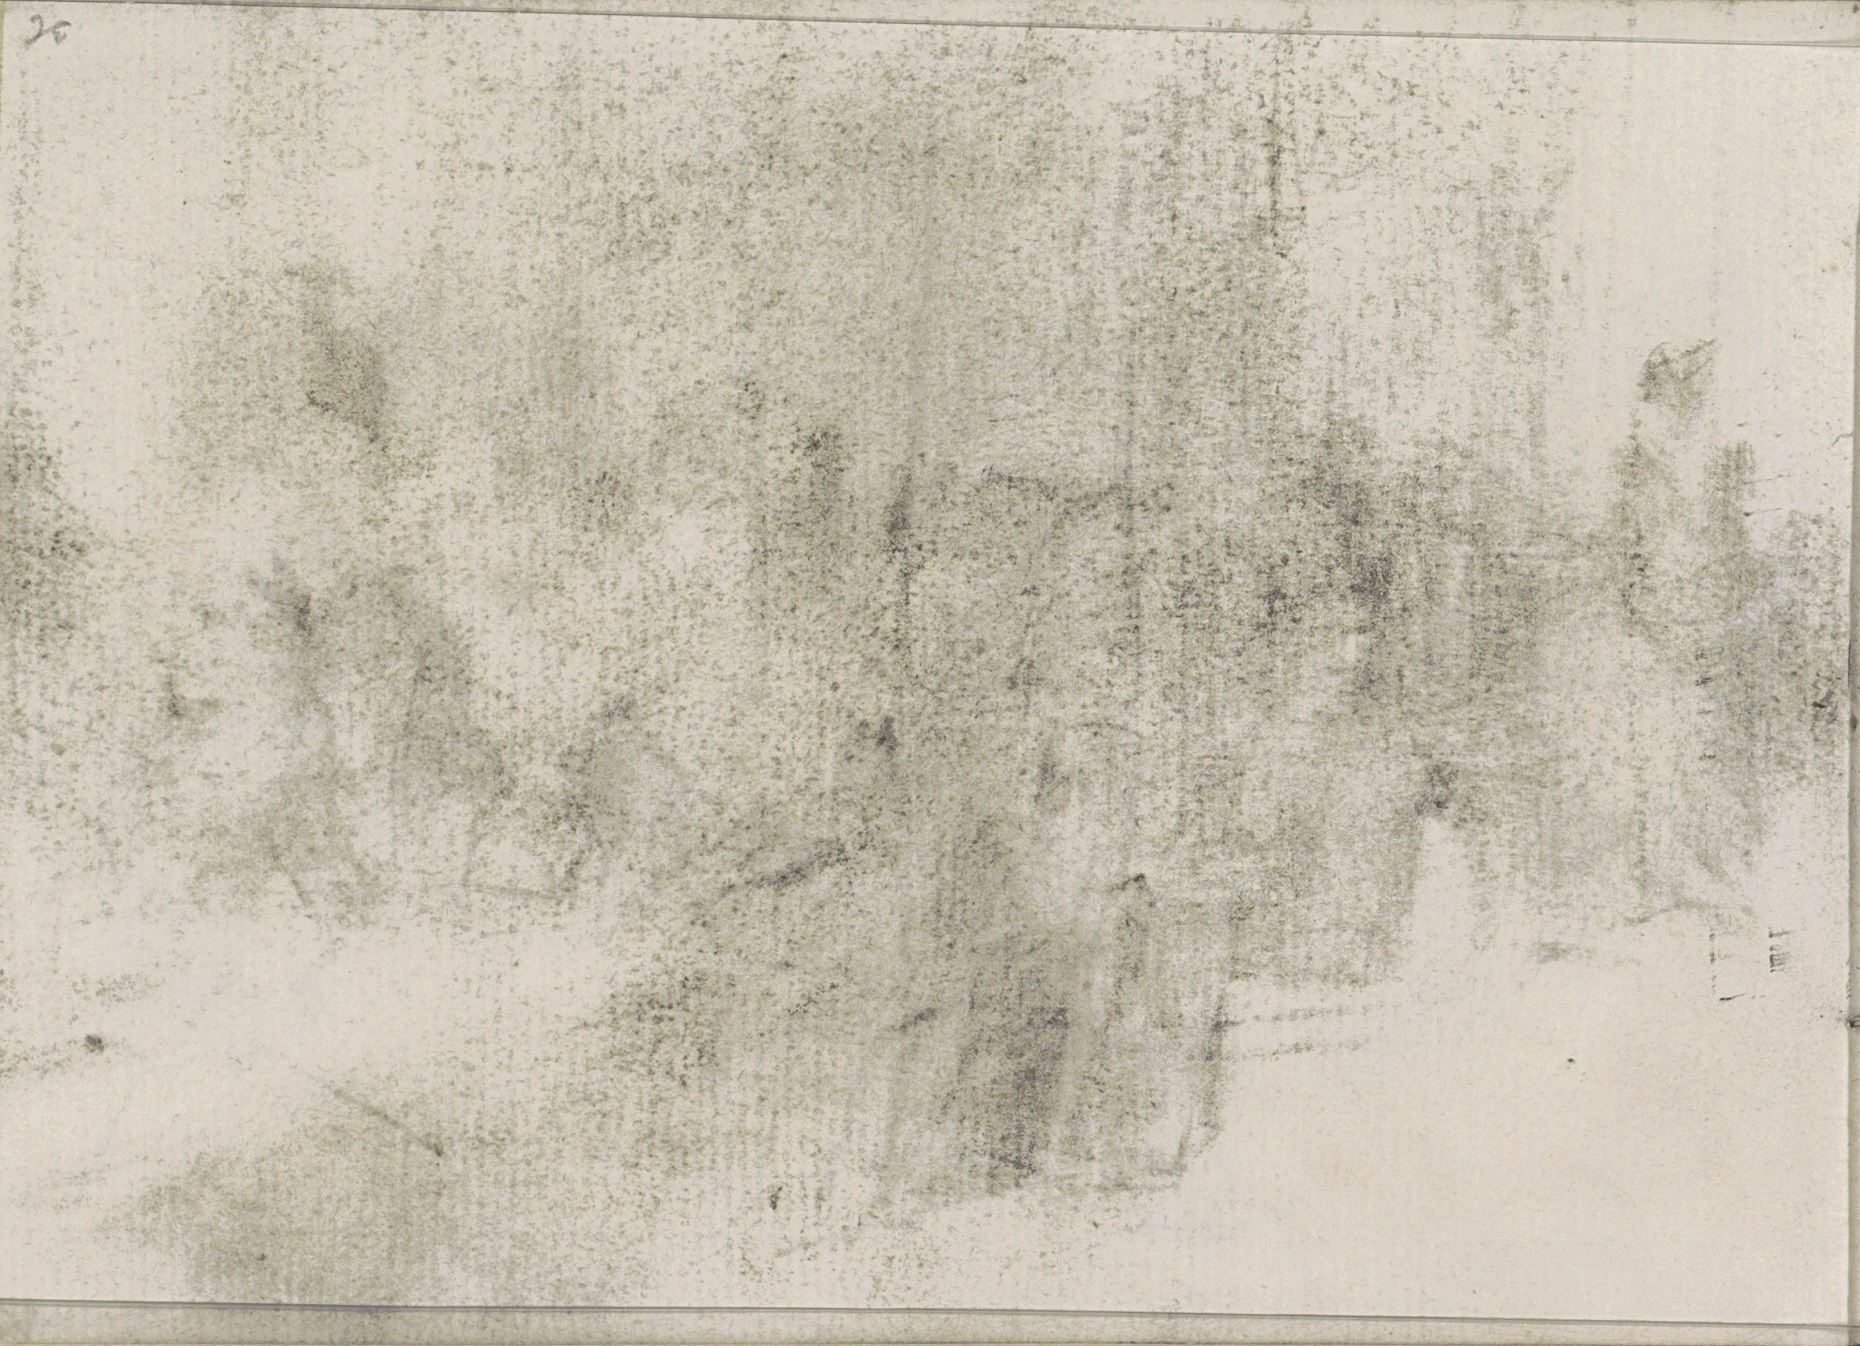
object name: sketchbook leaf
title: Abklatsch van de krijttekening op blad 18 recto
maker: isaac israels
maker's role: draughtsman, painter, print maker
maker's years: 1865-1934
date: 1875-1934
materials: paper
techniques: printmaking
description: Blad 17 verso uit schetsboek LVI met 26 bladen.